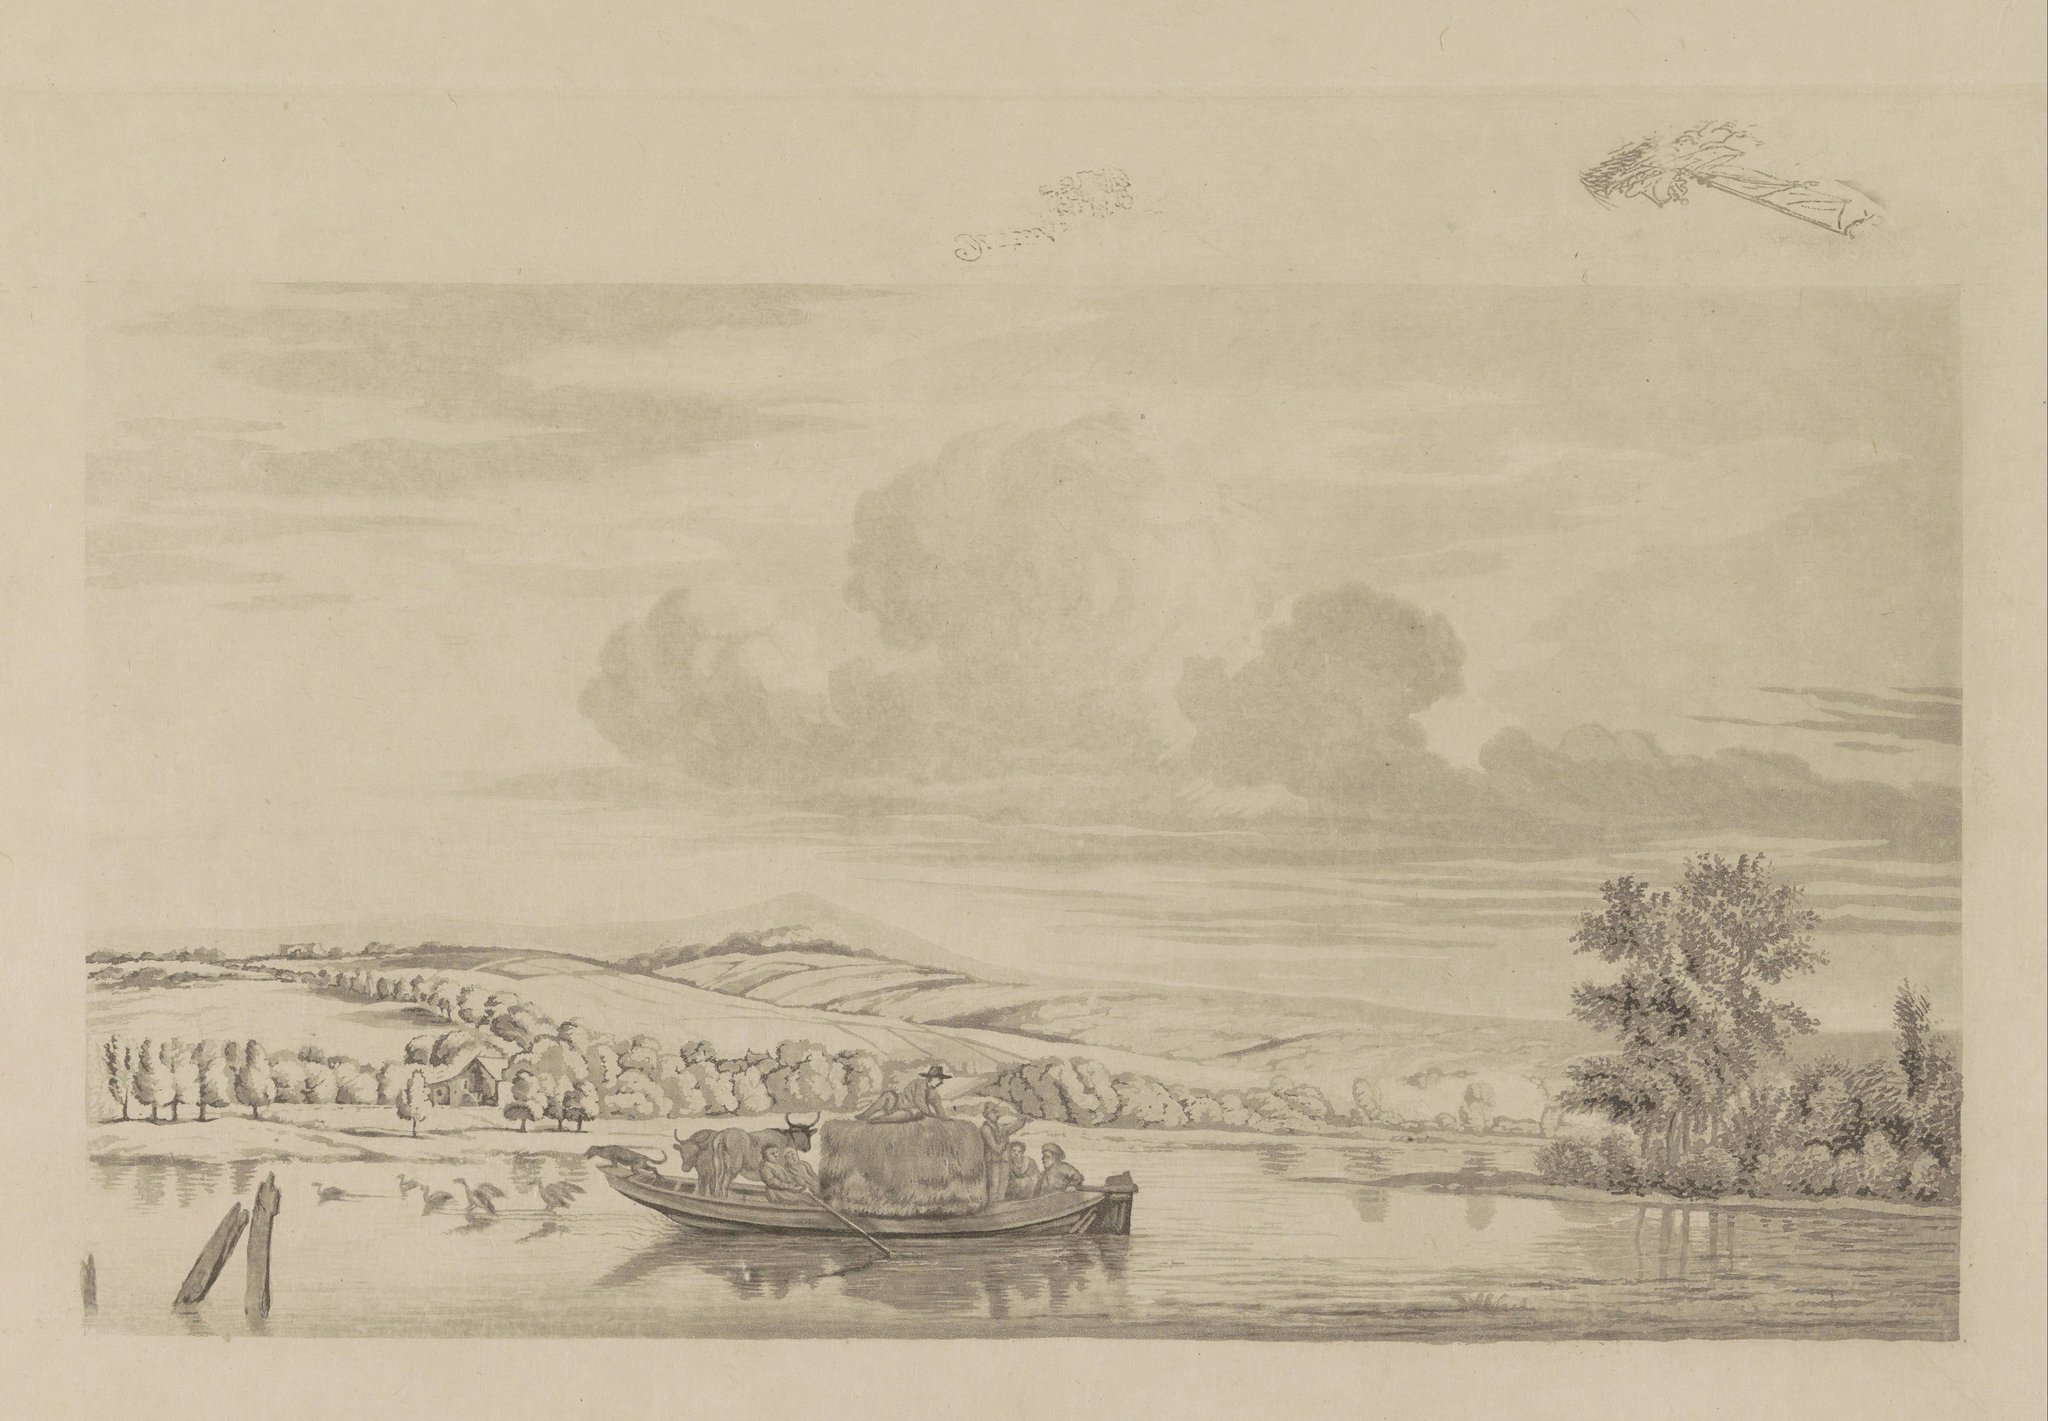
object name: print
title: Riviergezicht met hooischuit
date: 1795-1821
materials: paper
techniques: etching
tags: agricultural products and by-products: hay, ferry, landscapes (+ landscape with figures, staffage)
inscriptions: collector's mark: Lugt 2228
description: De voltooide prent werd opgenomen in: Collection d'imitations de dessins d'après les principaux maîtres hollandais et flamands, Londen, C. Josi, 1821.